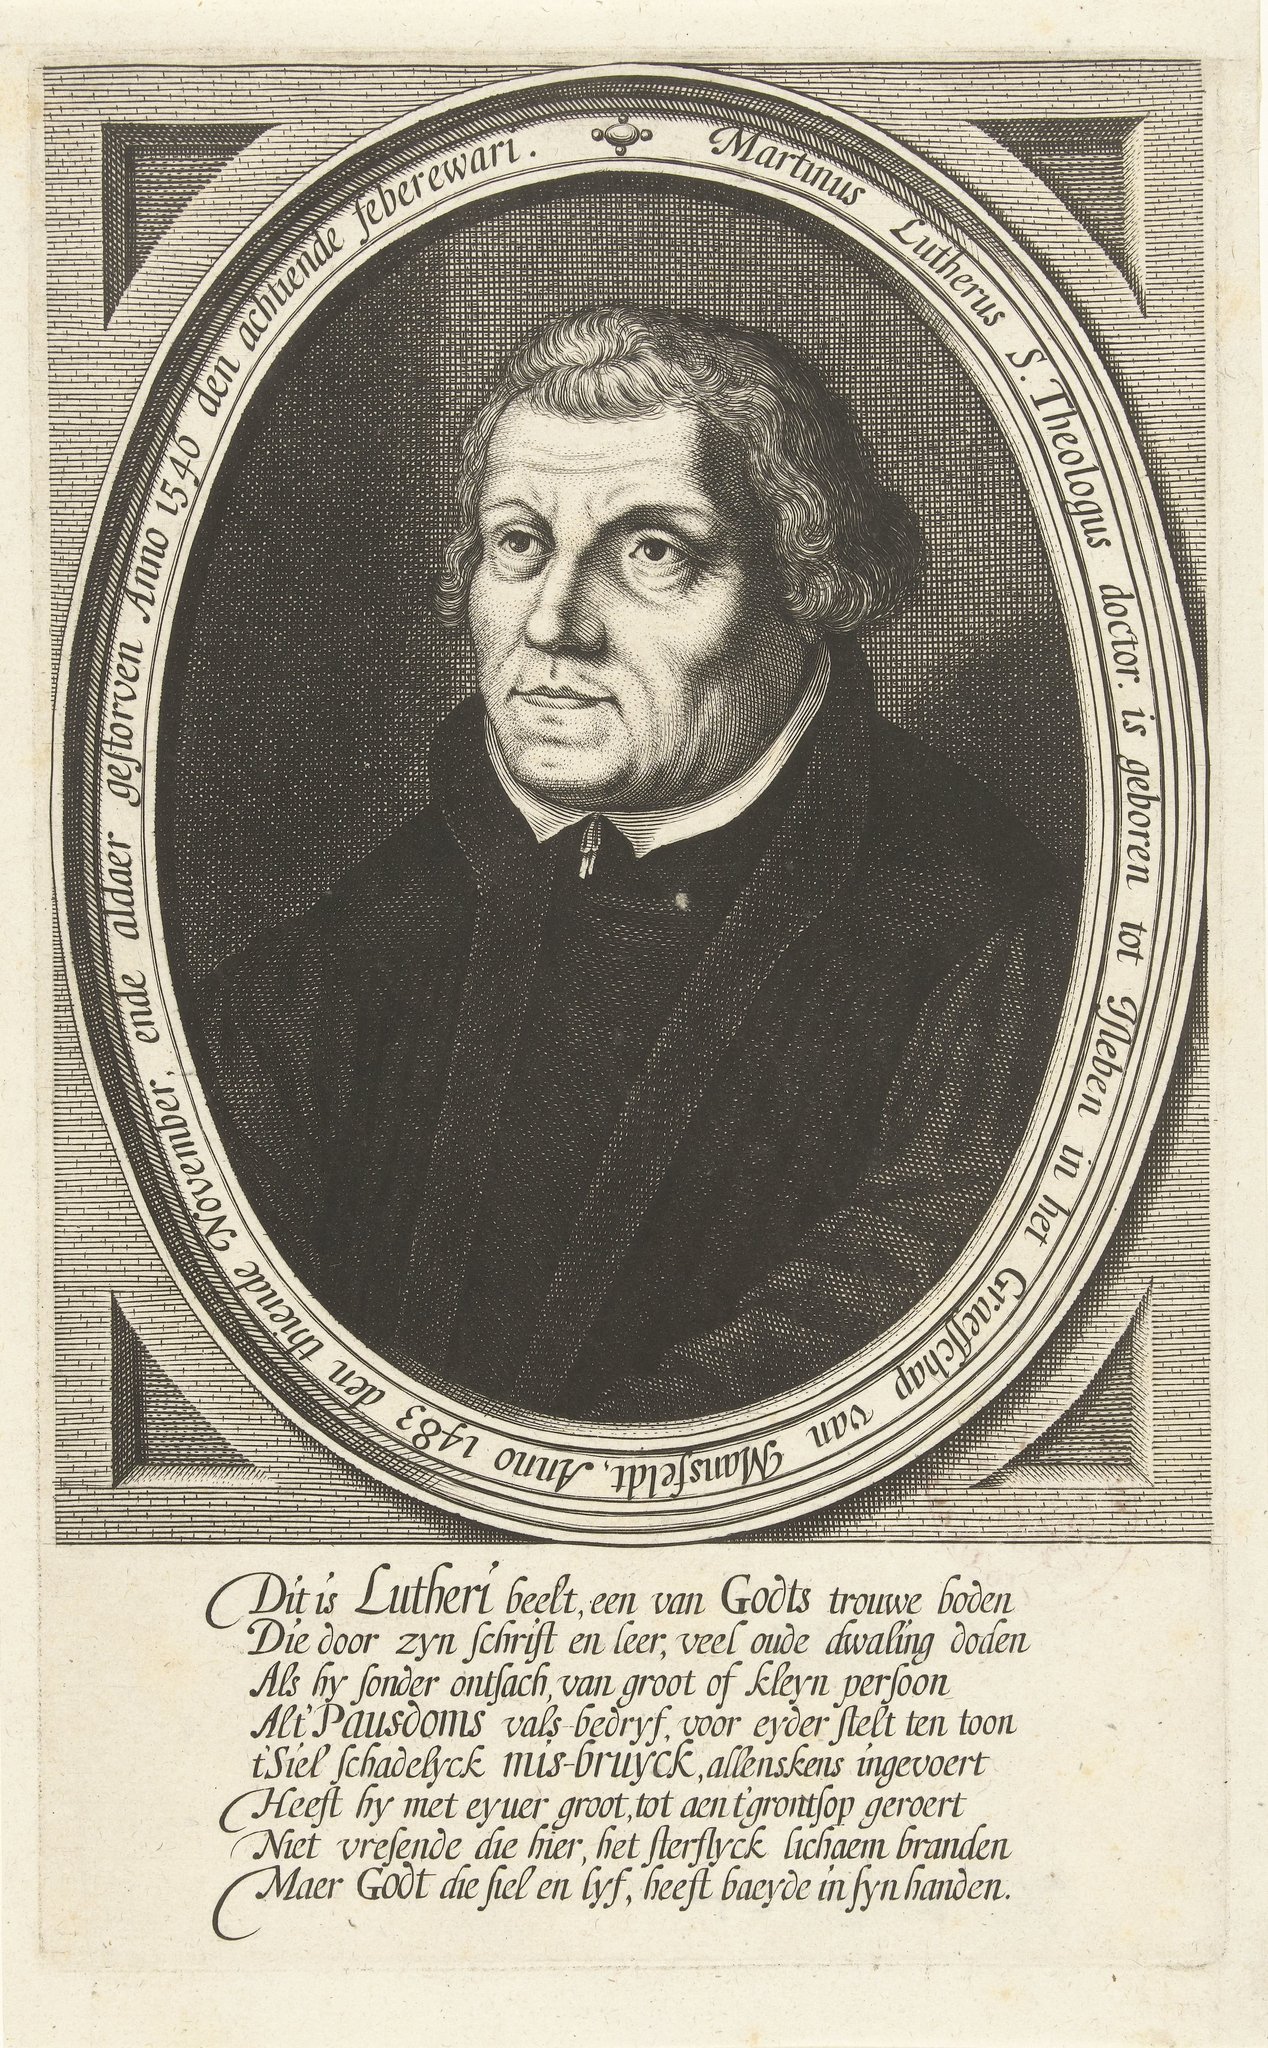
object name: print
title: Portret van Martin Luther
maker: Anonymous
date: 1590-1638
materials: paper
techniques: engraving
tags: priest, martin luther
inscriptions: collector's mark: Lugt 240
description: Portret van Martin Luther, borststuk in toga in ovale omlijsting met Nederlands opschrift. In ondermarge Nederlands vers in acht regels.